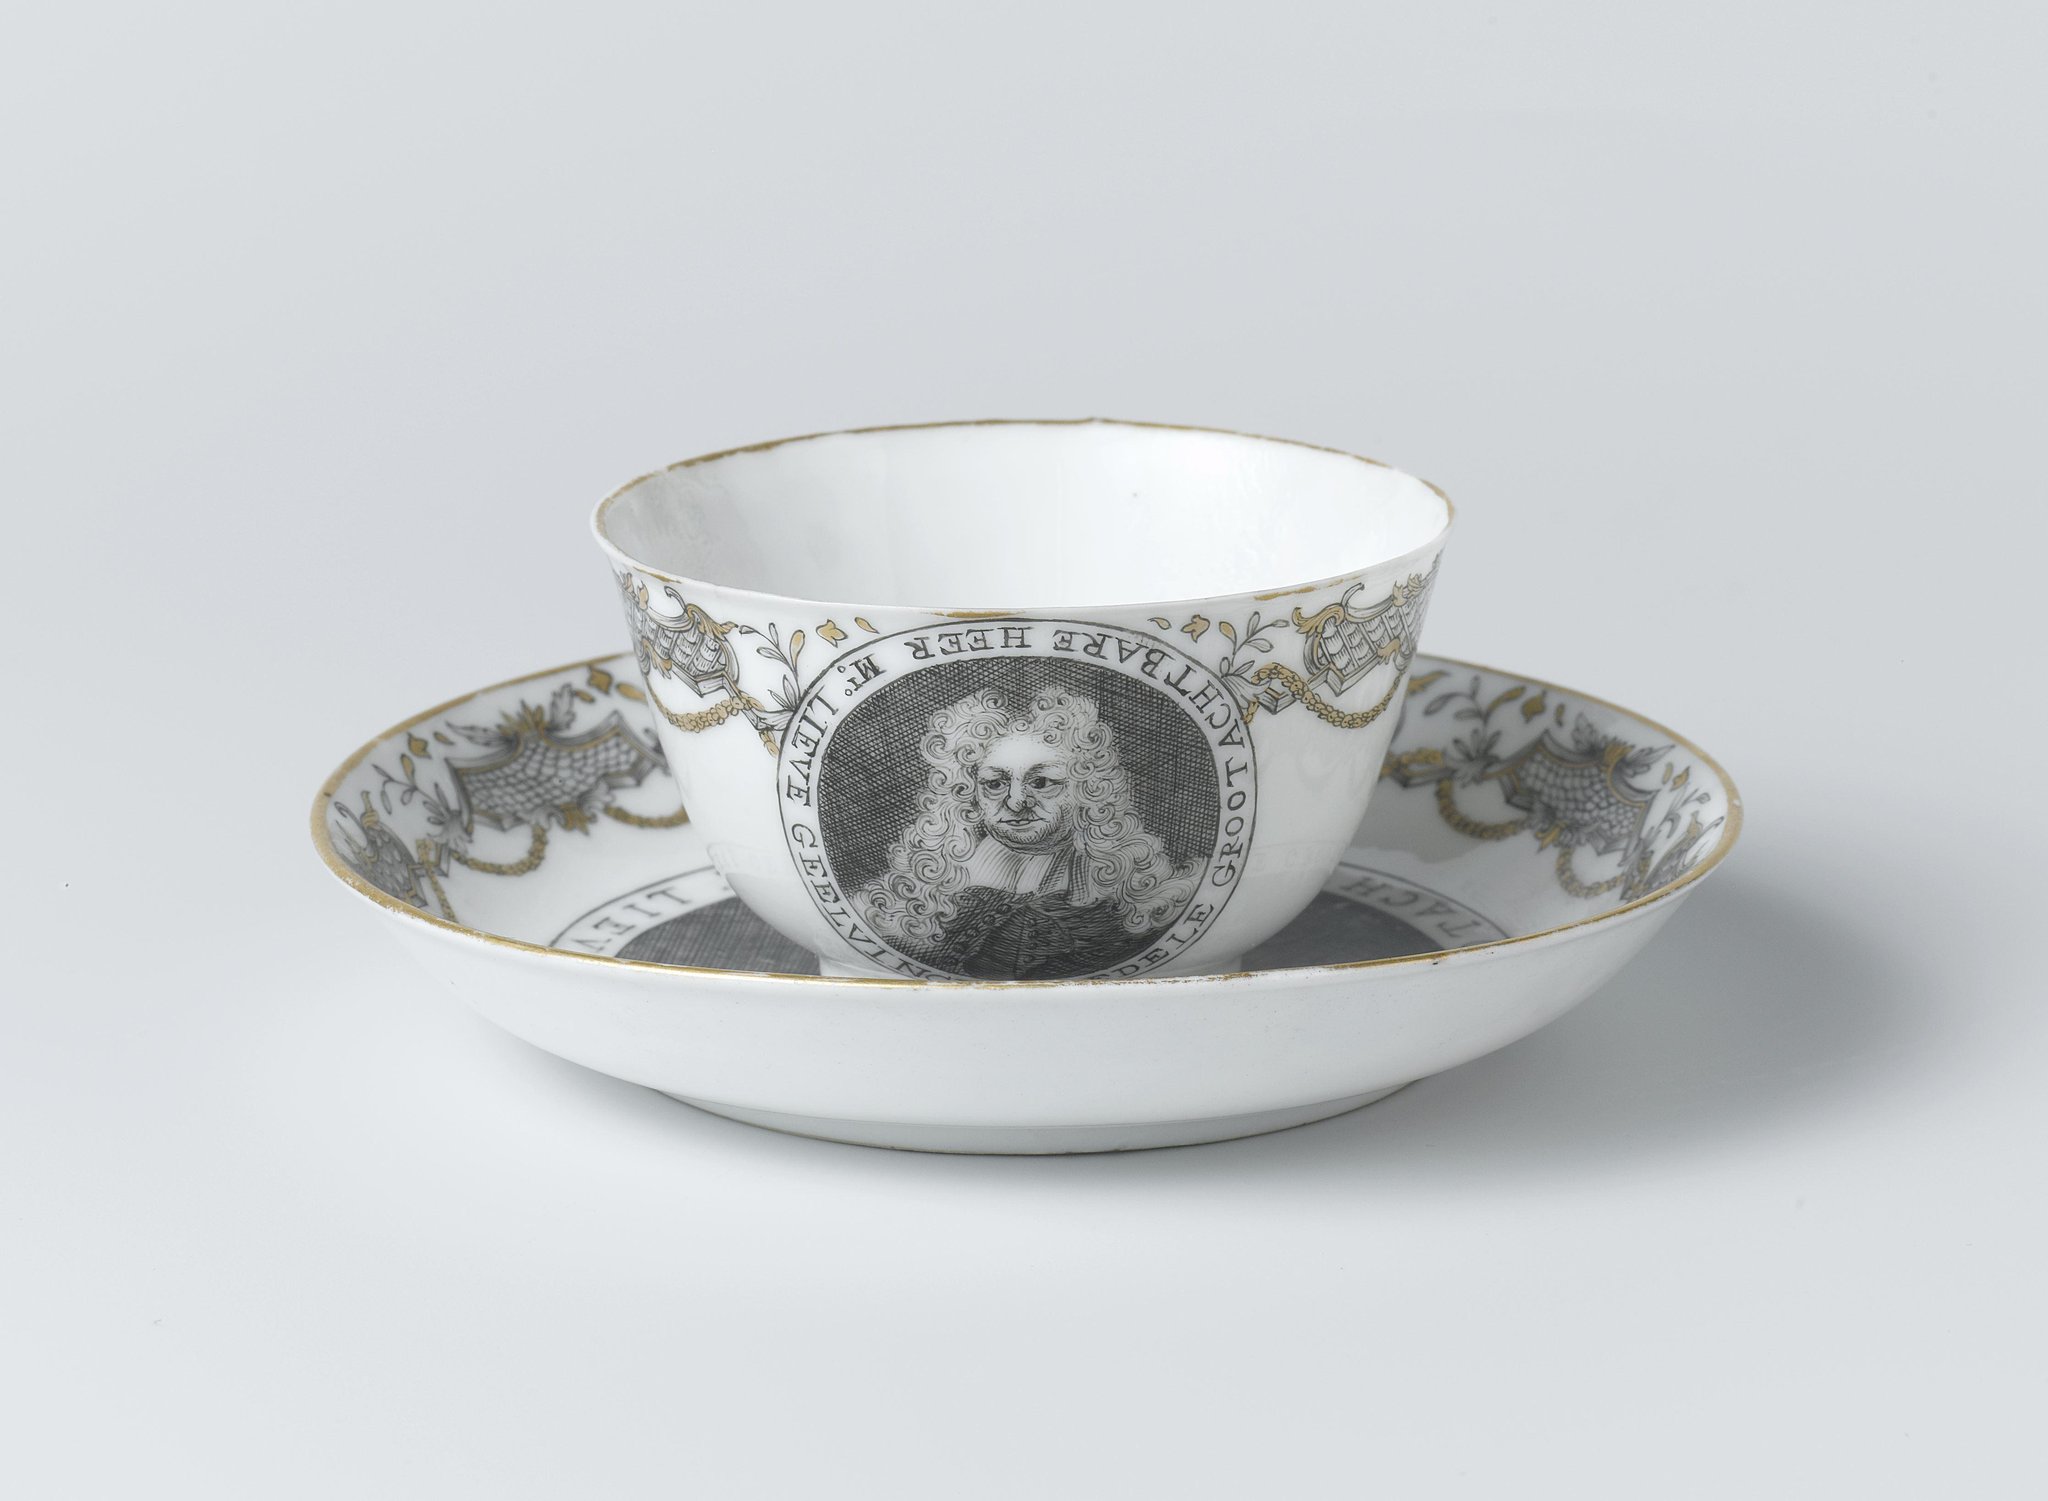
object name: kop en schotel, kop en schotel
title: Saucer with a portrait of Lieve Geelvinck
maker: Anonymous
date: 1760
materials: glaze, gold, paint, porcelain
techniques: firing, gilding, turning, vitrification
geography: netherlands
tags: amsterdam, mayor, lieve geelvinck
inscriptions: inscription: ‘DE EDELE GROOTACHTBARE HEER Mr. LIEVE GEELVINCK’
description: Het portret is een nauwkeurige kopie naar een gravure uit 1758 door Jacob Houbraken (1698-1780) en gebaseerd op een schilderij van Jan Wandelaar (1690-1759). Geelvinck was naast burgemeester van Amsterdam ook één van de directeuren van de VOC. Dit bood hem een uitstekende gelegenheid om Chine de commande porselein in China te laten vervaardigen. Hij bezat eveneens een polychroom servies voorzien van zijn wapen. Ook is een bord bekend met een allegorische voorstelling op zijn huwelijk met Jacoba Graafland in 1729. (C.J.A. Jörg en Jan van Campen, Chinese Ceramics in the Rijksmuseum, Londen 1997, p. 280)